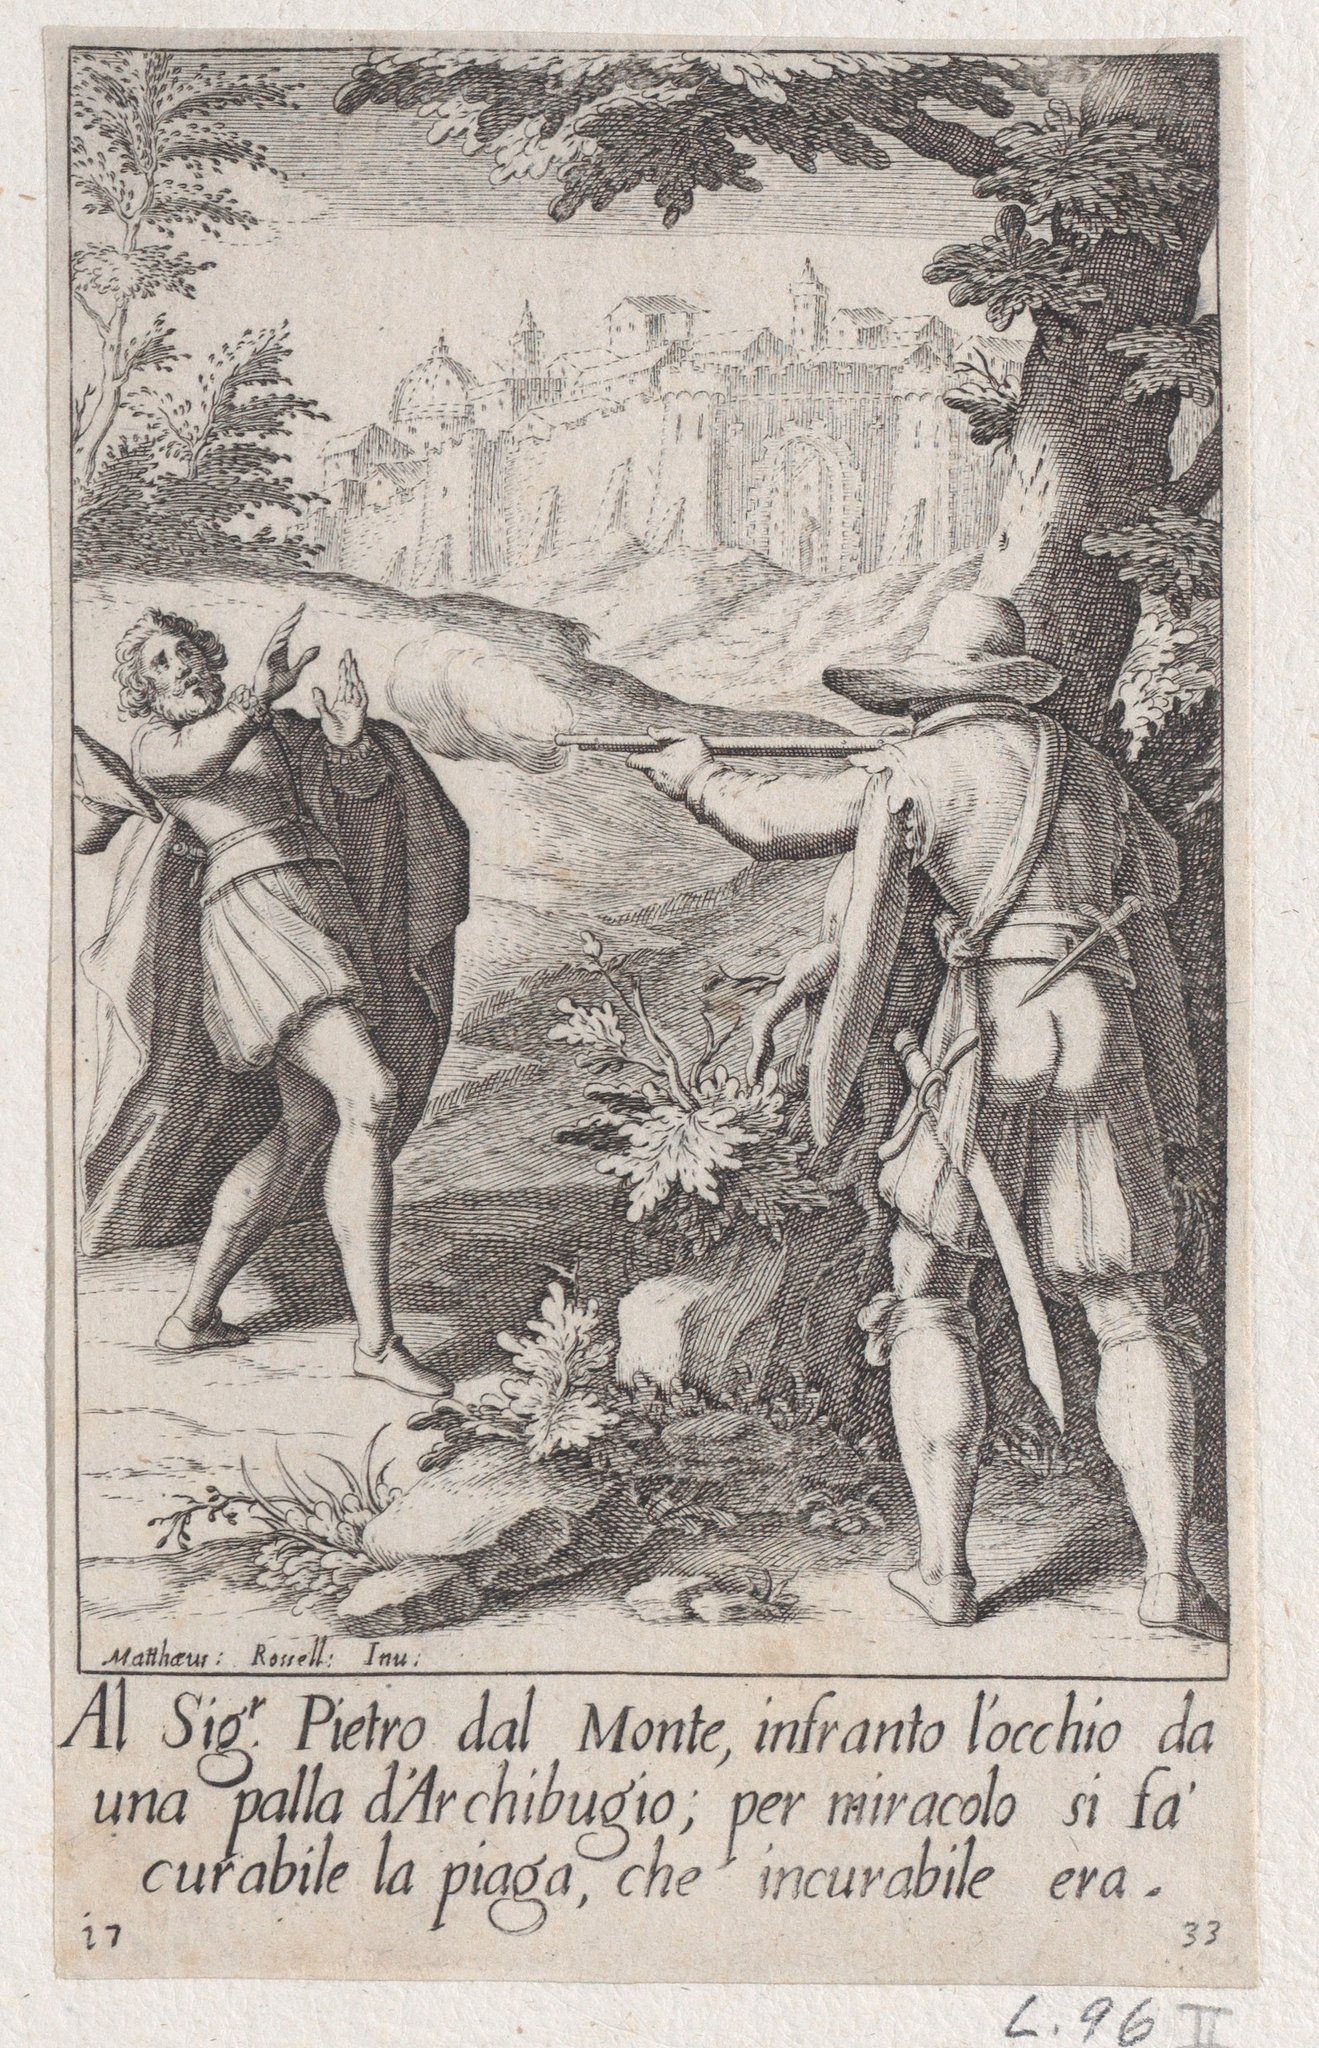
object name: print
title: Pietro dal Monte, from Scelta d'Alcuni Miracoli e Grazie della Santissima Nunziata di Firenze (Selection of Some Miracles and Graces that Occurred in the Church of the Annunziata in Florence)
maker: jacques callot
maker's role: artist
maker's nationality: french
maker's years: 1592-1635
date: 1611-1619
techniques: engraving